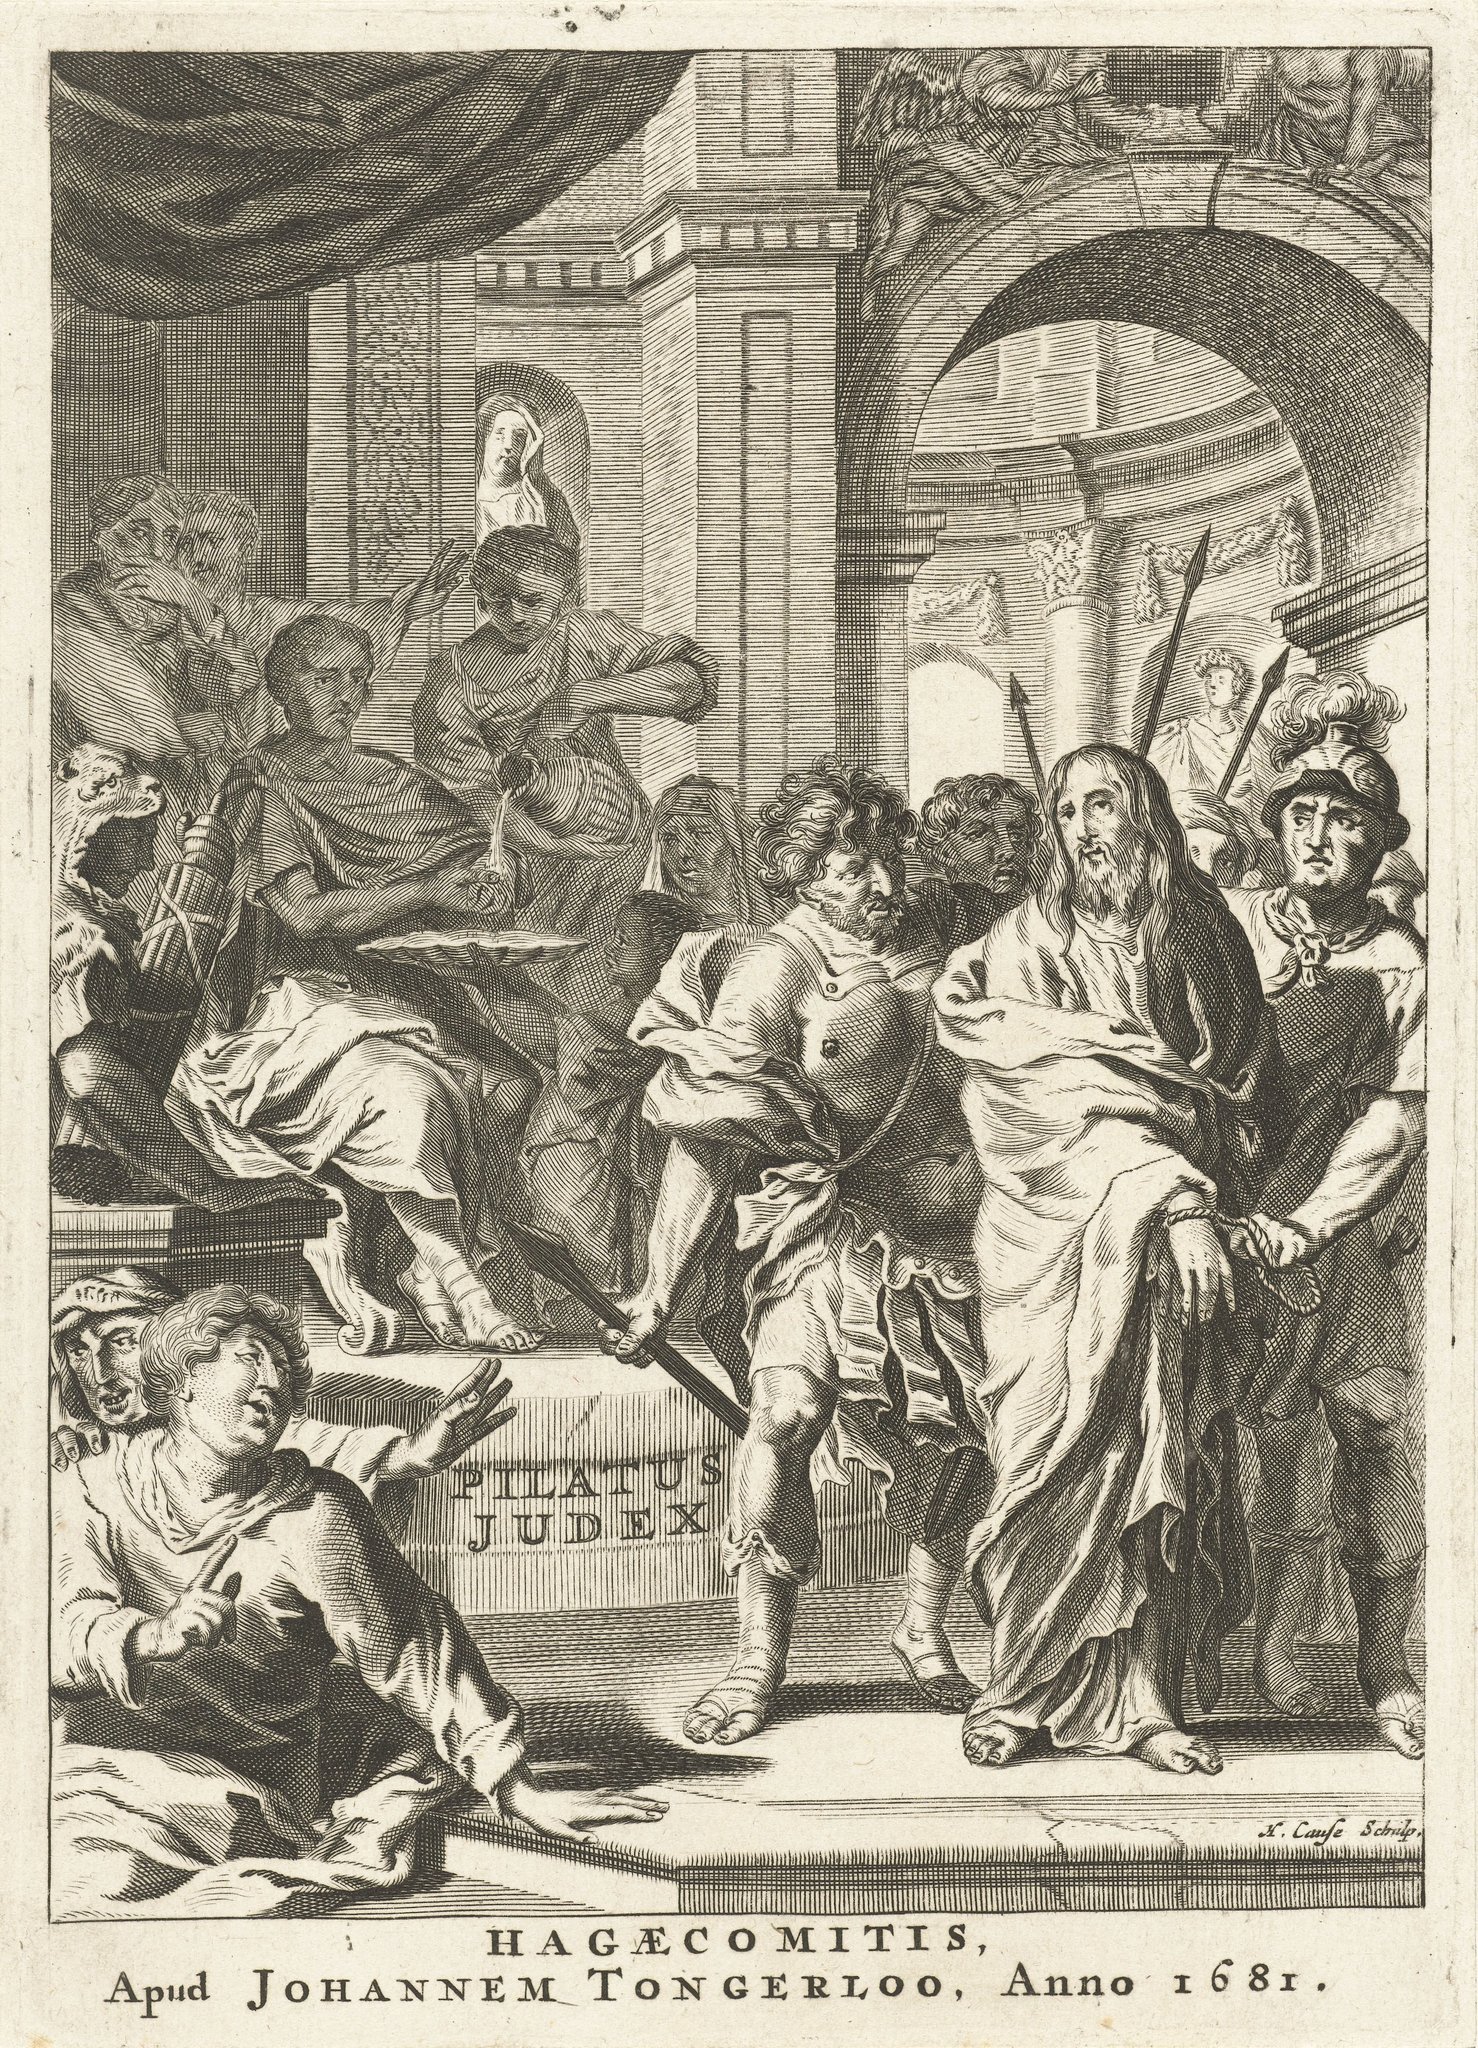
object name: titelblad, titelpagina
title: Titelpagina voor Wilelmus Goesius, Pilatus Judex, Den Haag, 1681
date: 1681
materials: paper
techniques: engraving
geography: southern netherlands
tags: christ before pontius pilate (matthew 27:11-26; mark 15:2-15; luke 23:2-7, 23:13-25; john 18:28 - 19:16), pilate washing his hands (in innocence)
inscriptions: collector's mark: Lugt 2760, collector's mark: Lugt 2228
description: Christus wordt door soldaten afgevoerd en door de omstanders bespot. Pilatus die op een troon zit wast zijn handen in onschuld.